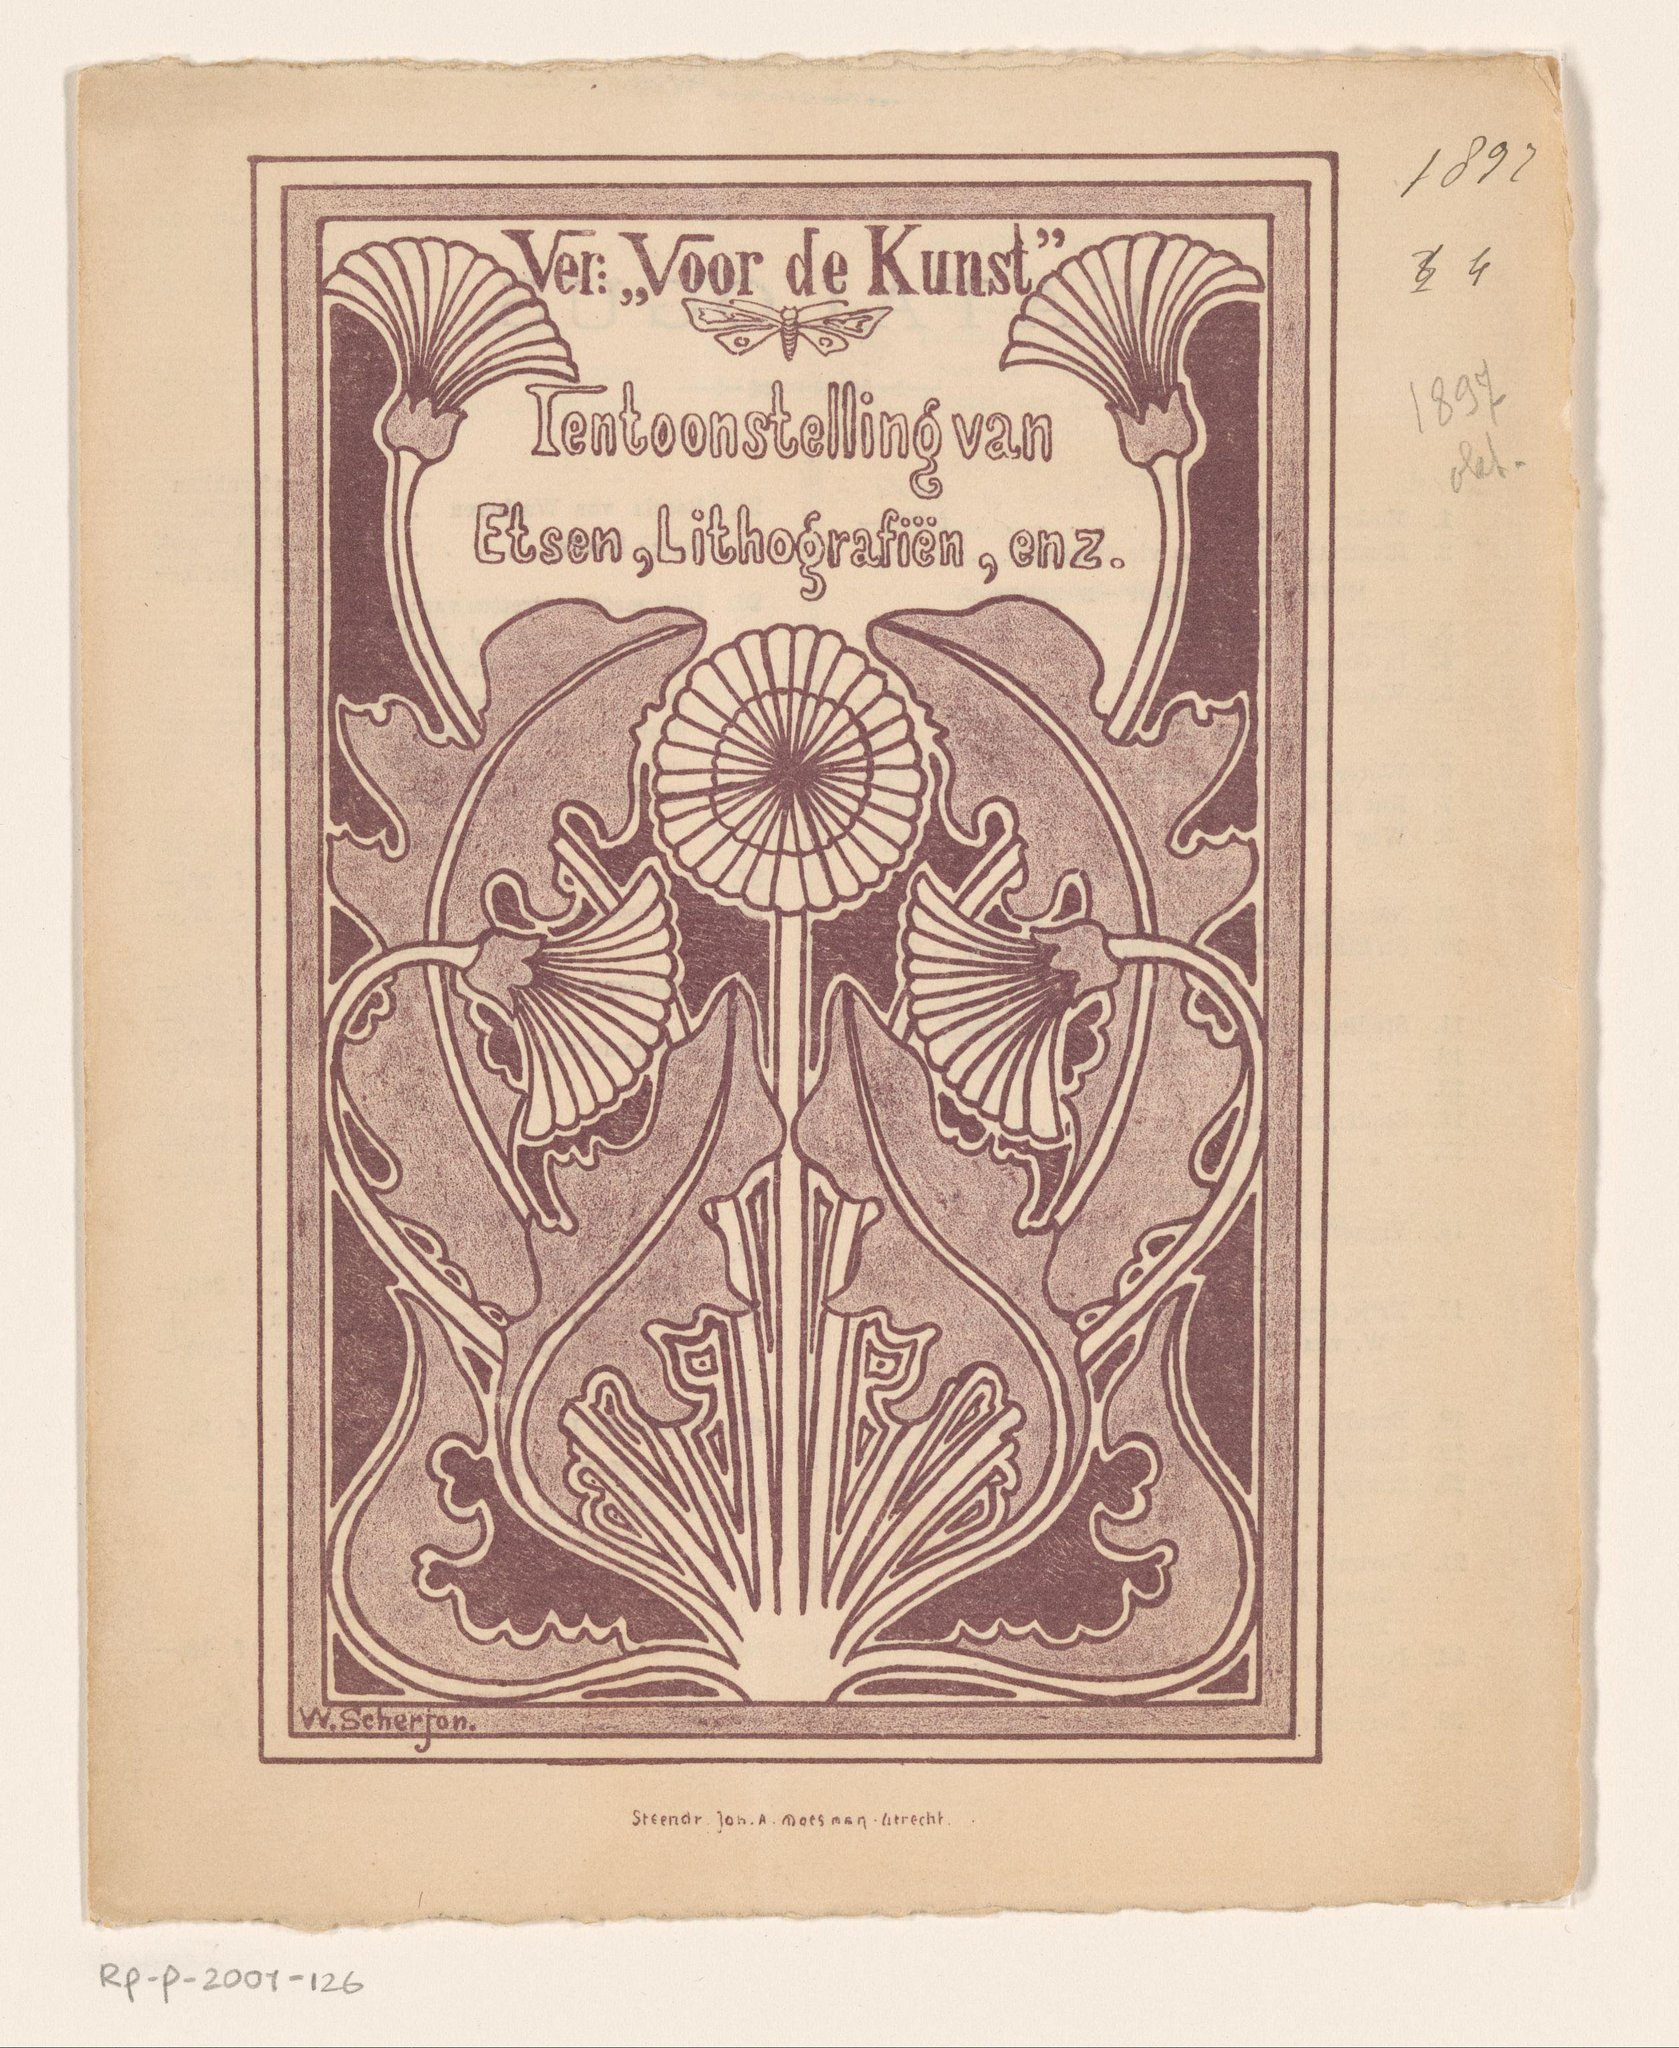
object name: print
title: Tentoonstellingscatalogus van de Vereniging Voor de Kunst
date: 1810-1897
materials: paper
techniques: lithograph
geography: utrecht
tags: ornament derived from plant forms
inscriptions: collector's mark: Lugt 2760, collector's mark: Lugt 2228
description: In de binnenzijde van de omslag zijn werken opgenomen van de kunstenaars: M. Bauer, Mevrouw Bisschop-Robertson, Johannes Bosboom, Etienne Bosch, P. Dupont, Dijsselhof, Vincent van Gogh, Seymour Haden, H. J. Haverman, Jozef Israëls, Isaac Israëls, P. de Josselin de Jong, Jongkind, Max Liebermann, Adolph Menzel, Wally Moes, Th. Molkenboer, S. Moulijn, W Roelofs, Segantini, M. van der Valk, Jan Veth, en De Zwart.